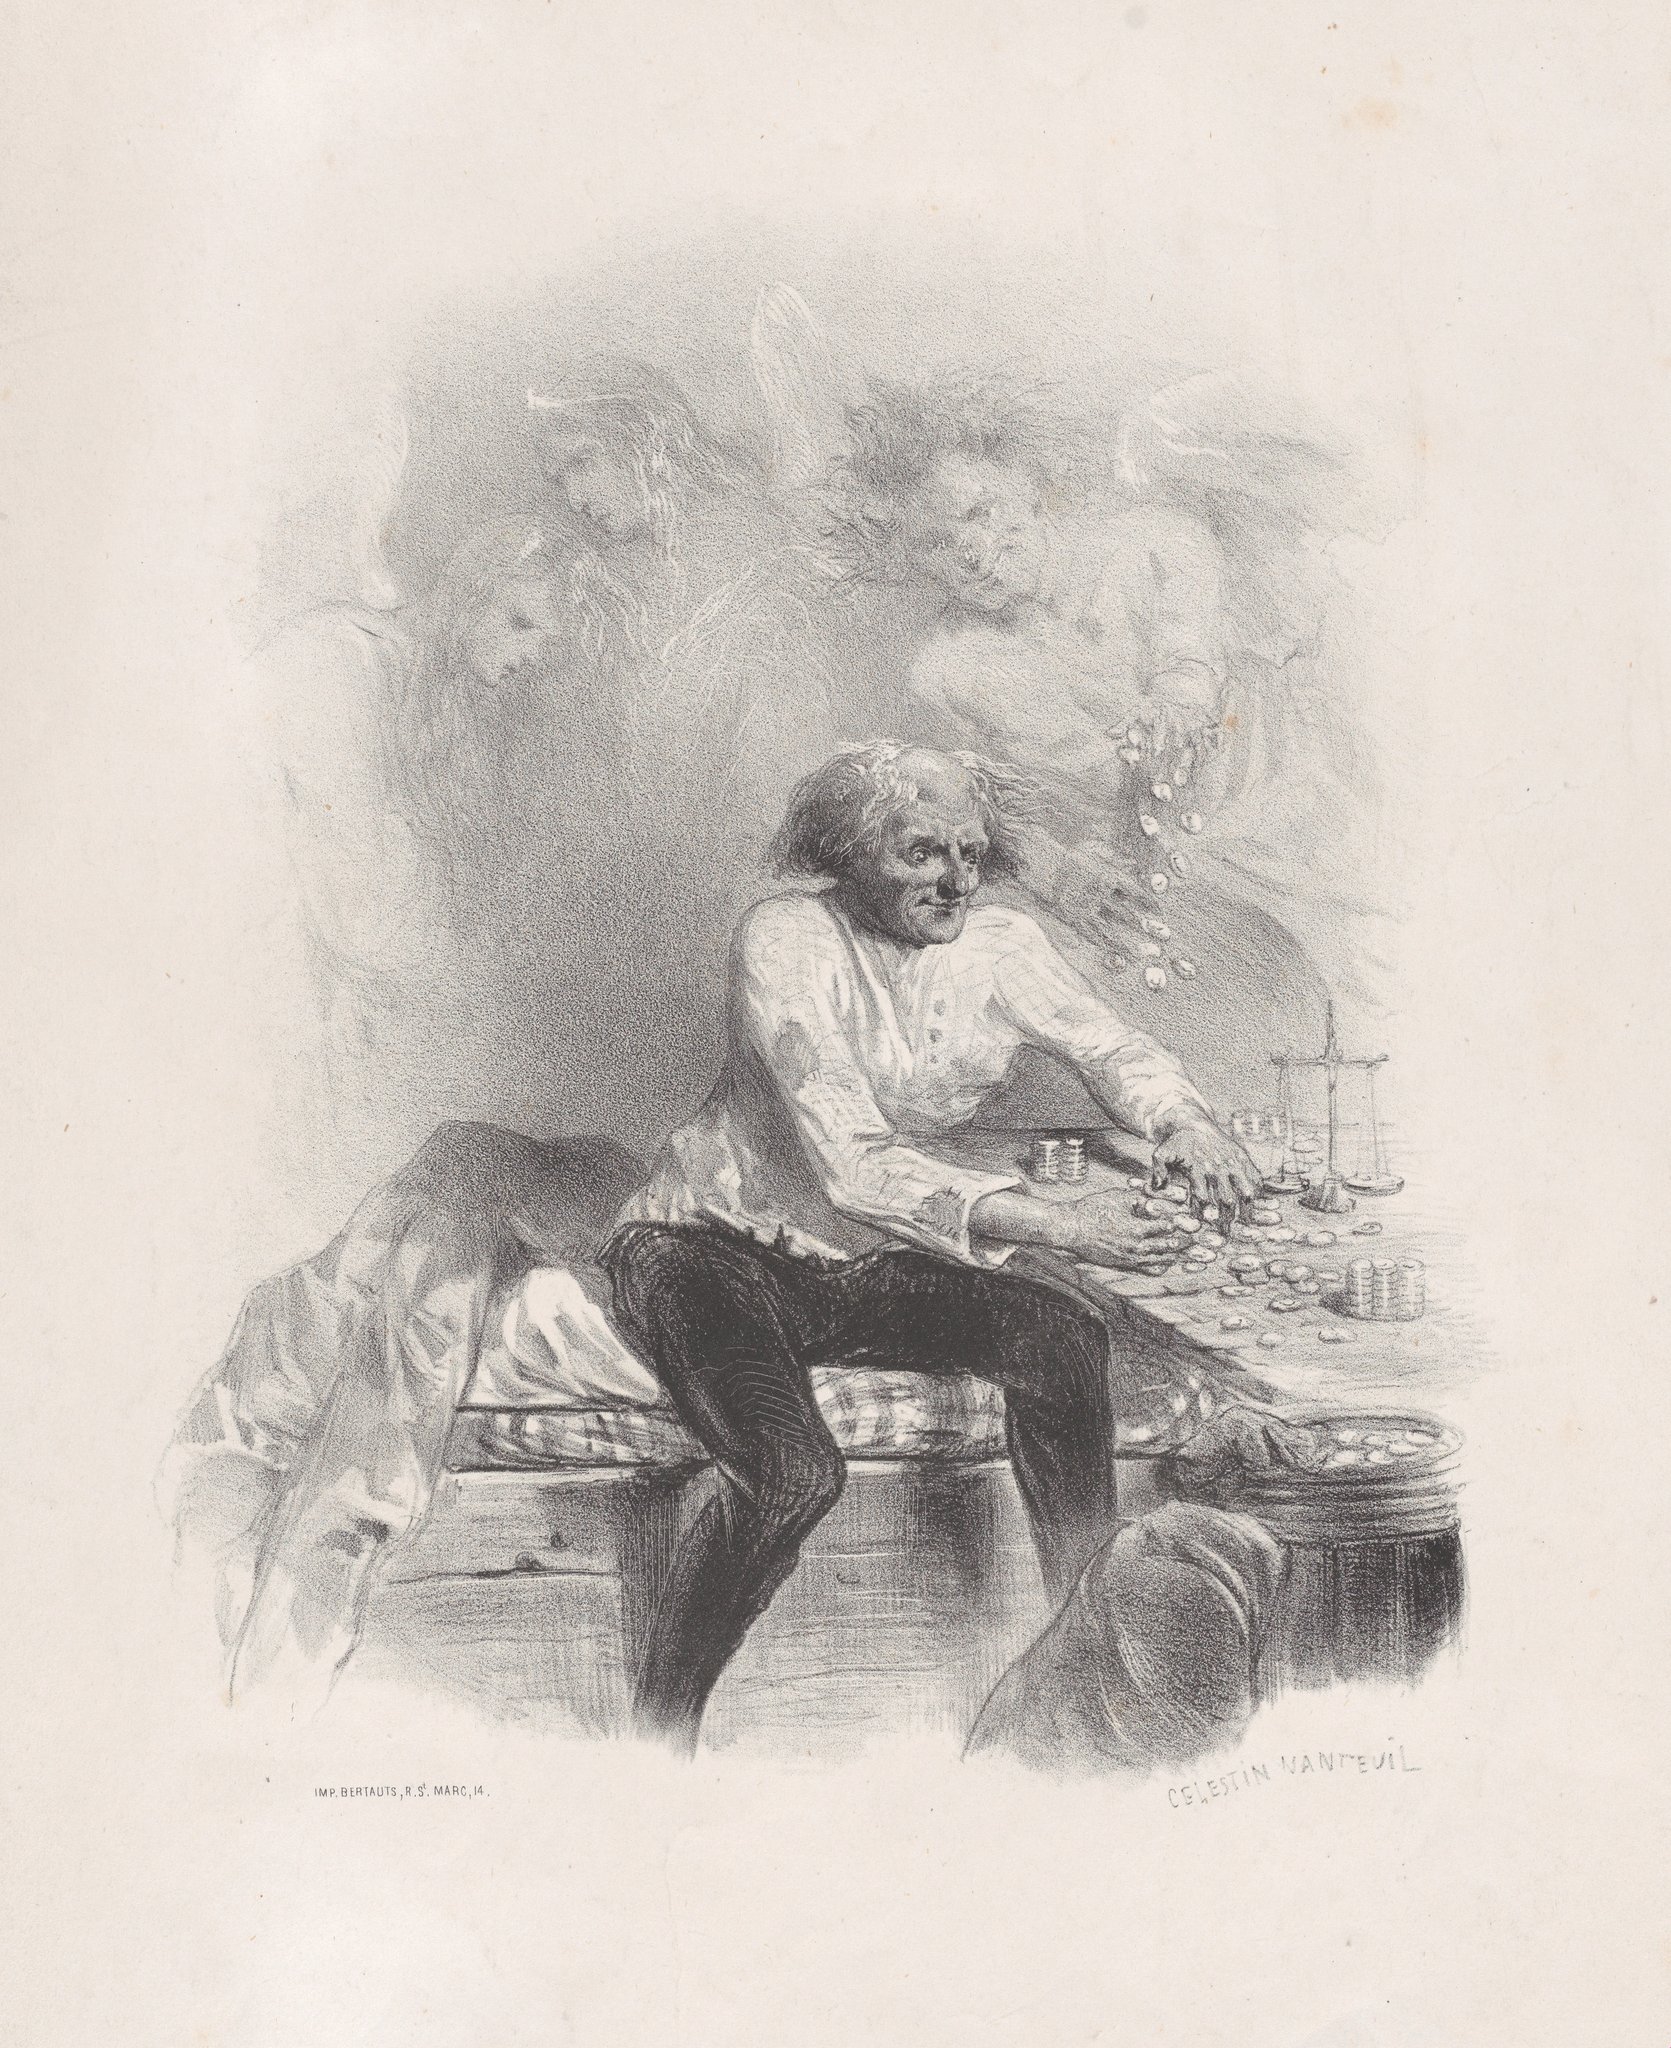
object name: print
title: Old Man Counting Money at a Table with a Scale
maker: célestin nanteuil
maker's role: artist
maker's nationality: french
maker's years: 1813-1873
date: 1830-1860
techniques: lithograph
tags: men,money